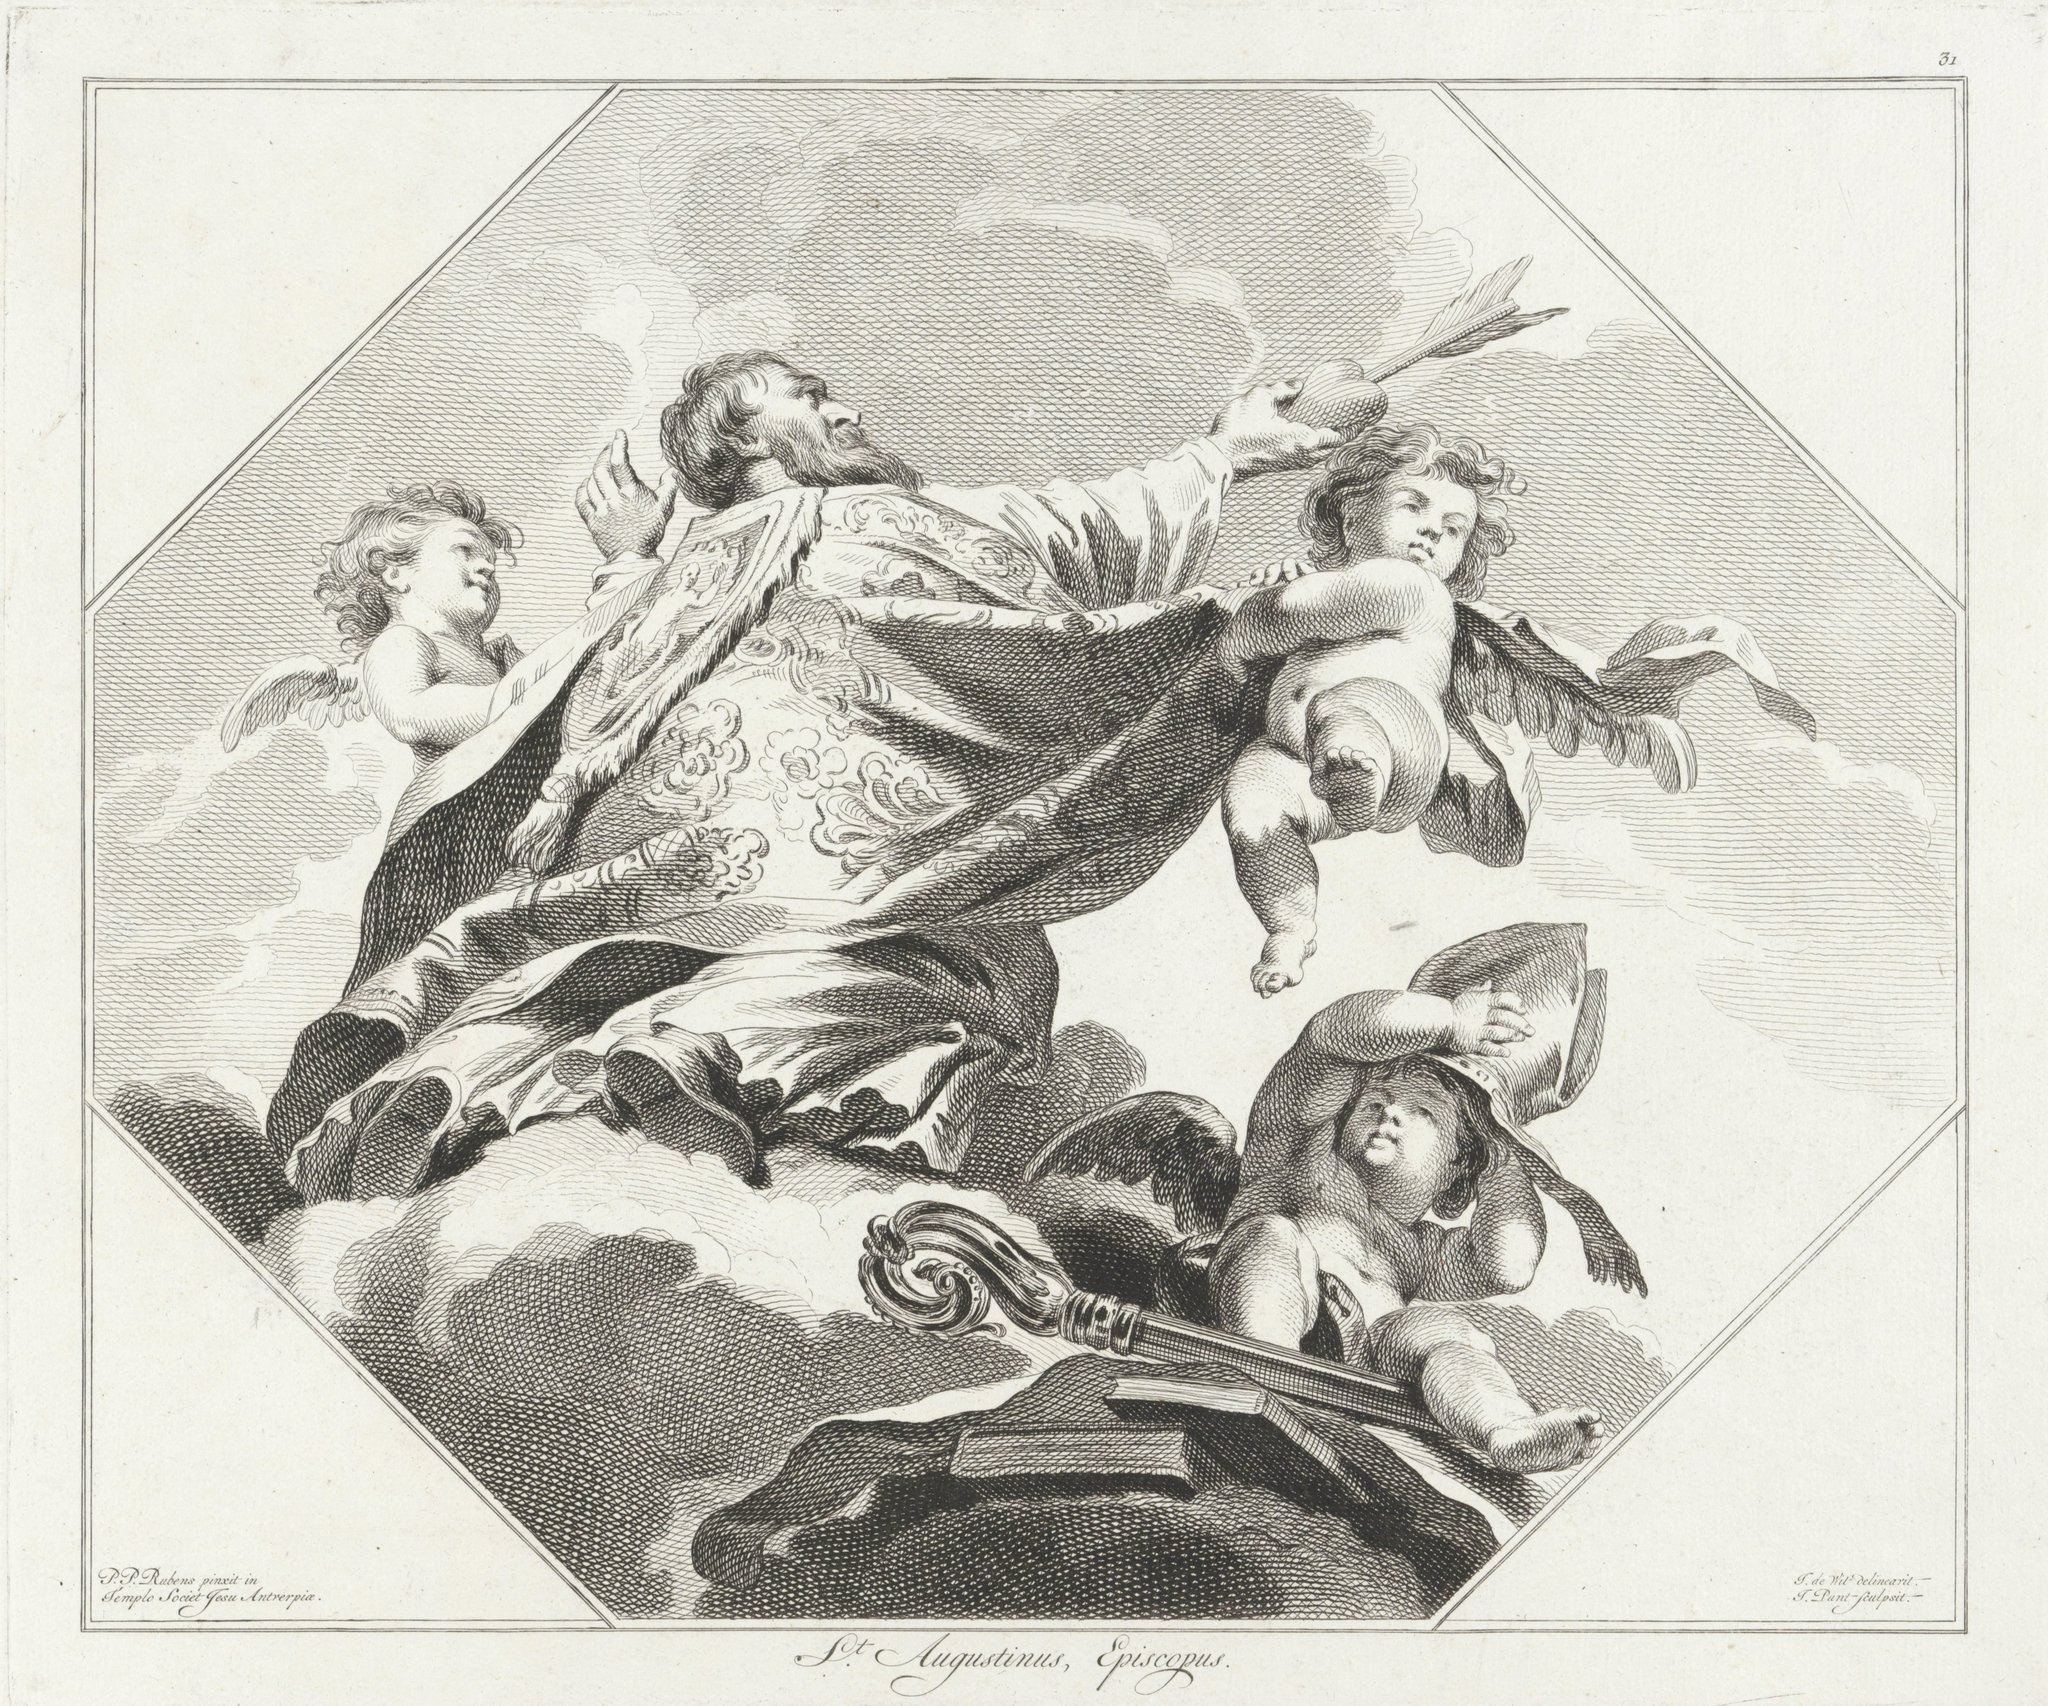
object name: print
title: H. Augustinus van Hippo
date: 1751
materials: paper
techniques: engraving, etching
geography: amsterdam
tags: augustine, bishop of hippo; possible attributes: arrows piercing his breast, book, child with spoon, flaming heart, heart (pierced with arrows), pen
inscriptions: collector's mark: Lugt 240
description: De heilige Augustinus van Hippo, in bisschopsgewaad, een met een pijl doorboord hart in de hand. Hij is vergezeld door drie engeltjes, van wie één de mijter en de bisschopsstaf draagt. Onder de octagonale voorstelling een opschrift in het Latijn.